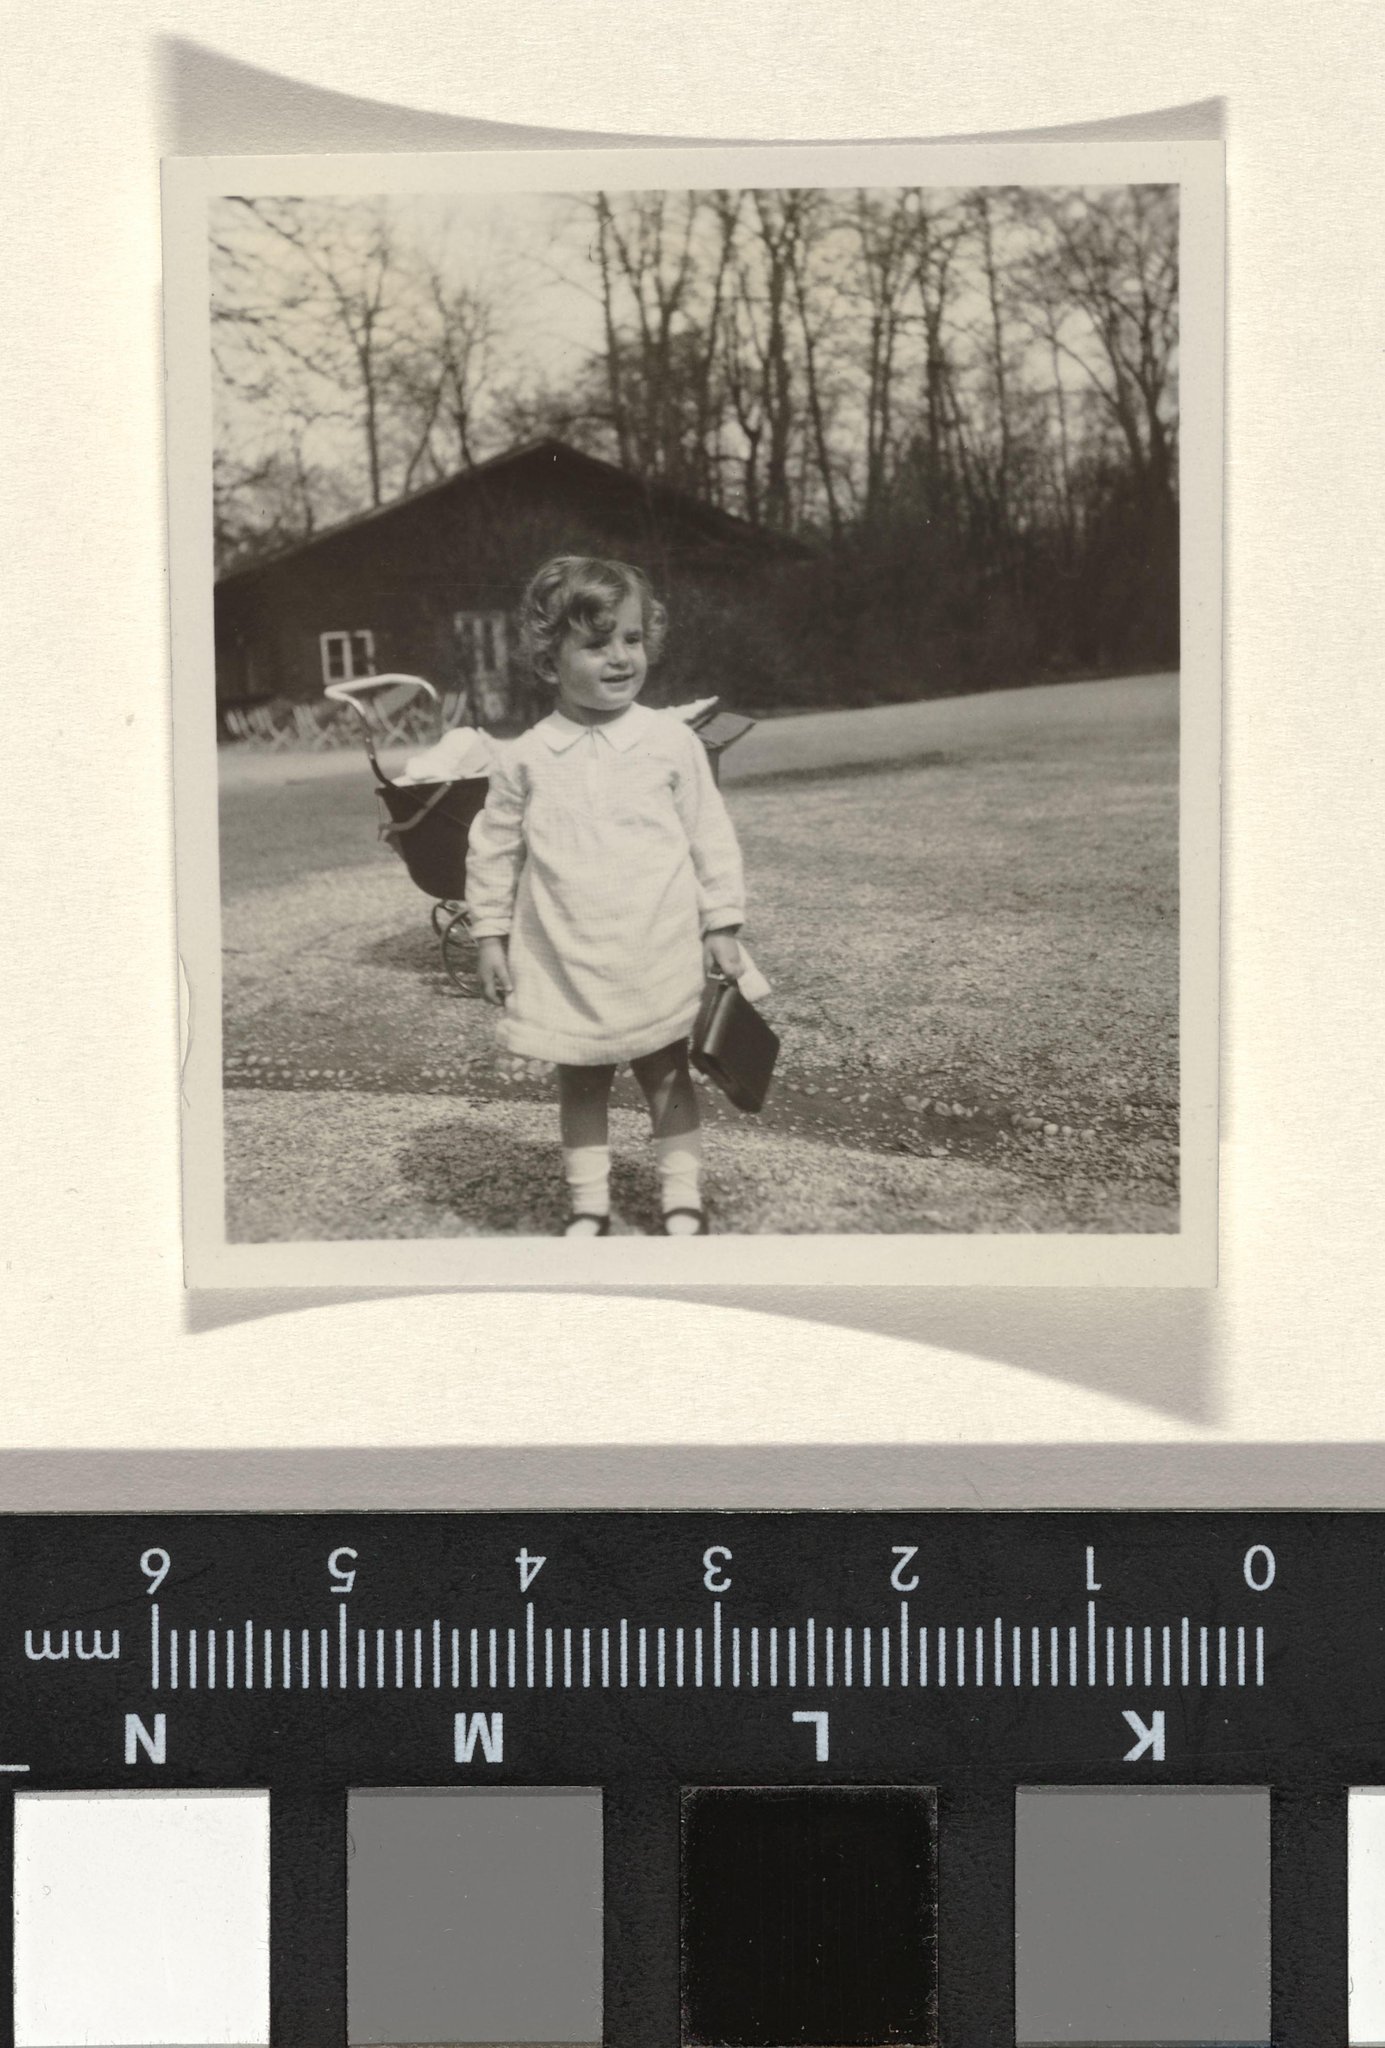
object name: photograph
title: Isabel Wachenheimer, Engelse Tuinen, München, september 1930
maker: Anonymous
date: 1909-1930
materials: photographic support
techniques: gelatin silver print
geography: munich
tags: isabel wachenheimer-elon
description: Dit object is onderdeel van de nalatenschap van Isabel Elon-Wachenheimer (1928-2010). Tot haar overlijden behoorde het samen met de andere objecten uit de nalatenschap tot haar privédomein van Isabel Wachenheimer. In die particuliere context zijn deze objecten tezamen en individueel aandenkens - aan de jeugd, ouders en familie van Isabel Wachenheimer vóór en tijdens de Shoah en aan haar leven na de Tweede Wereldoorlog. Isabel Wachenheimer, die van juni 1943 tot mei 1945 gevangen zat in Kamp Westerbork, Theresienstadt, Auschwitz, Lenzing a/d Oberdonau (een buitenkamp van Mauthausen), overleefde de Shoah. Haar ouders – Eugène Wachenheimer en Else Wachenheimer-Moos - werden op 14 oktober 1944 in Auschwitz-Birkenau vermoord.